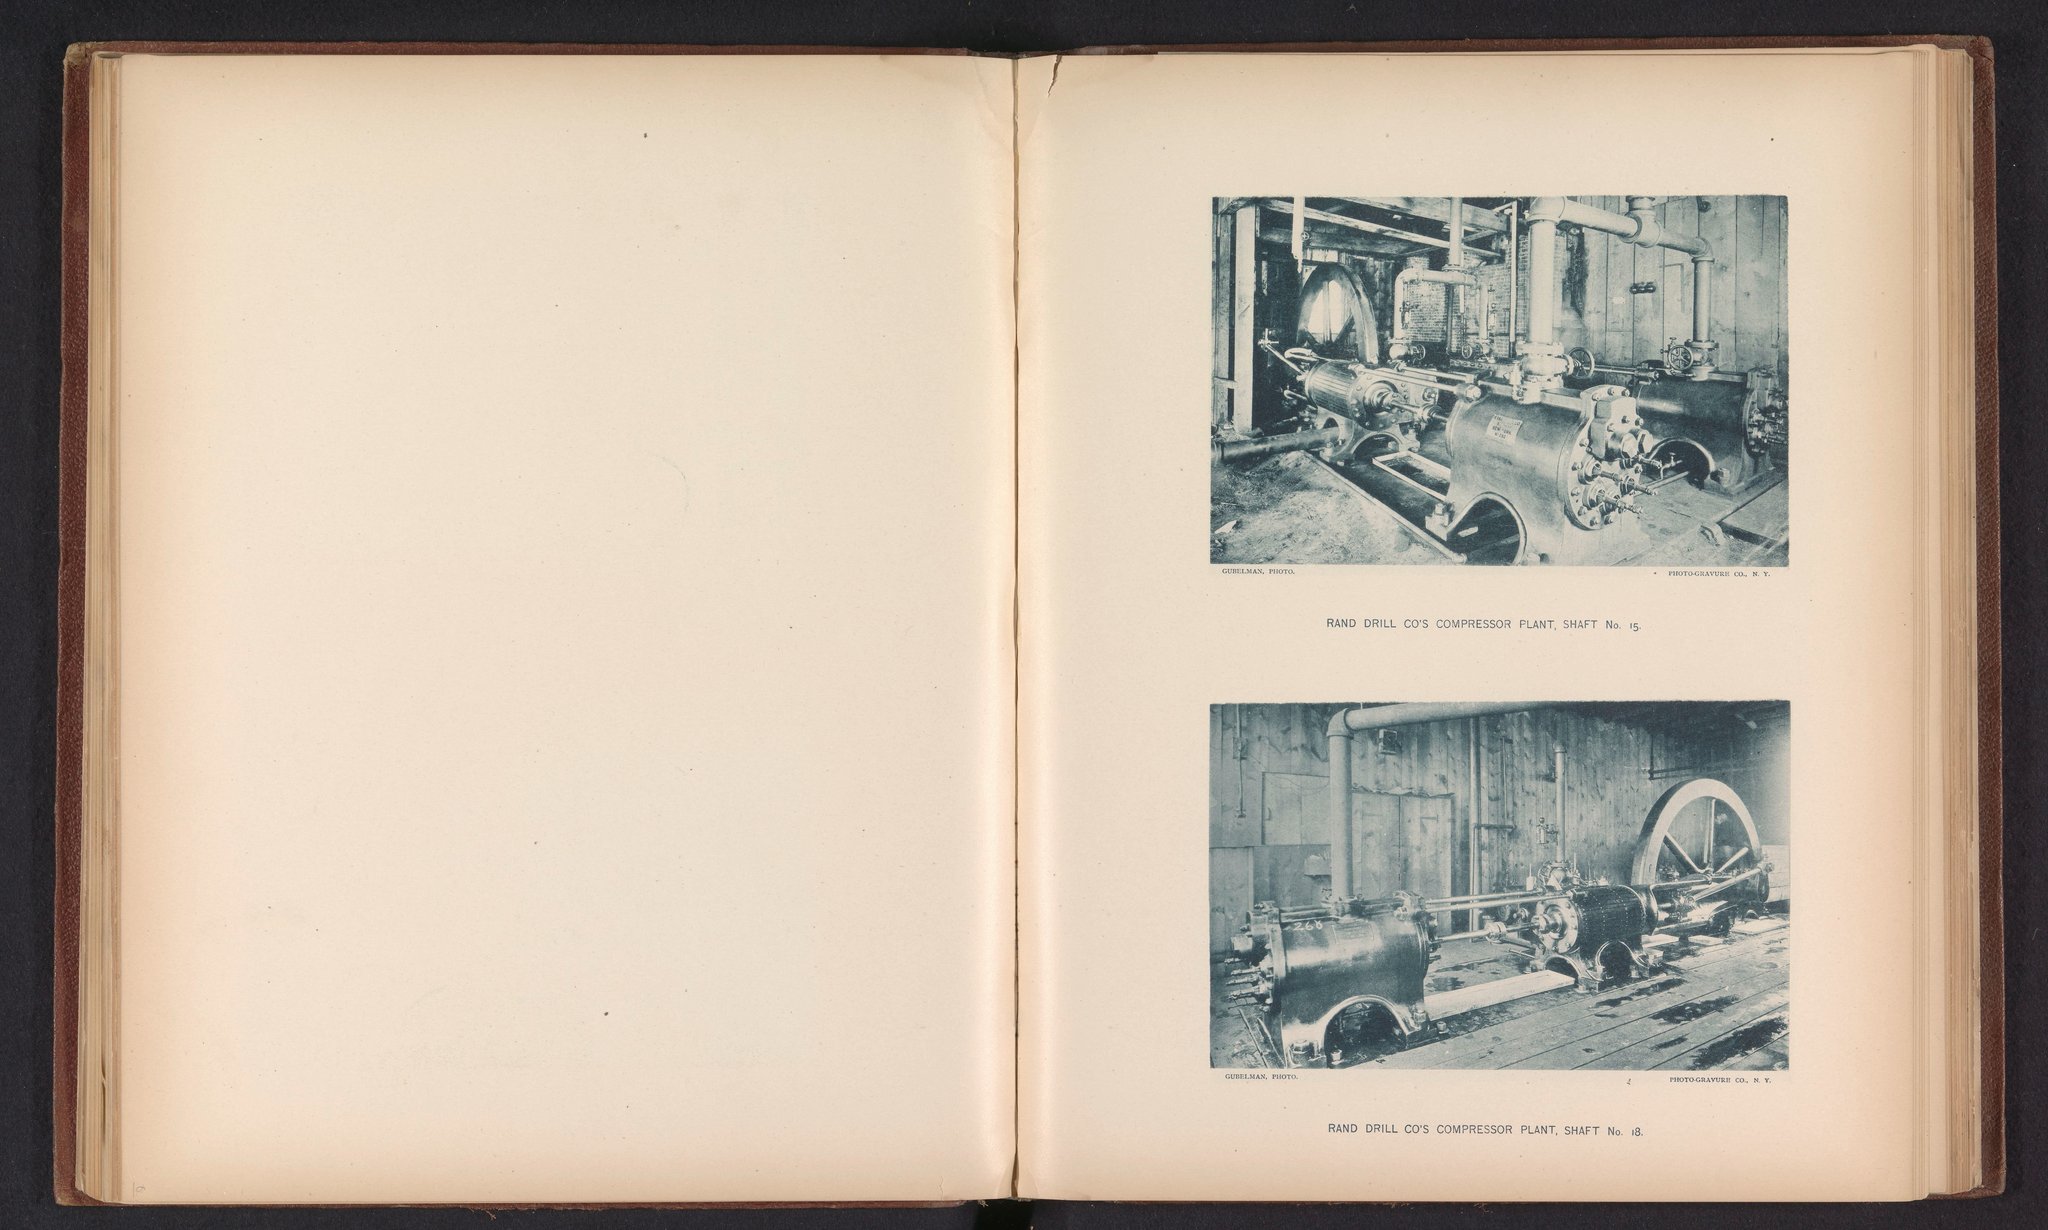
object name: page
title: Rand Drill co's compressor plant, shaft no. 15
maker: preston k. yates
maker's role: engineer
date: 1883-1887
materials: paper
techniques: photograph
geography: new york city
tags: machines; parts of machines; tools and appliances